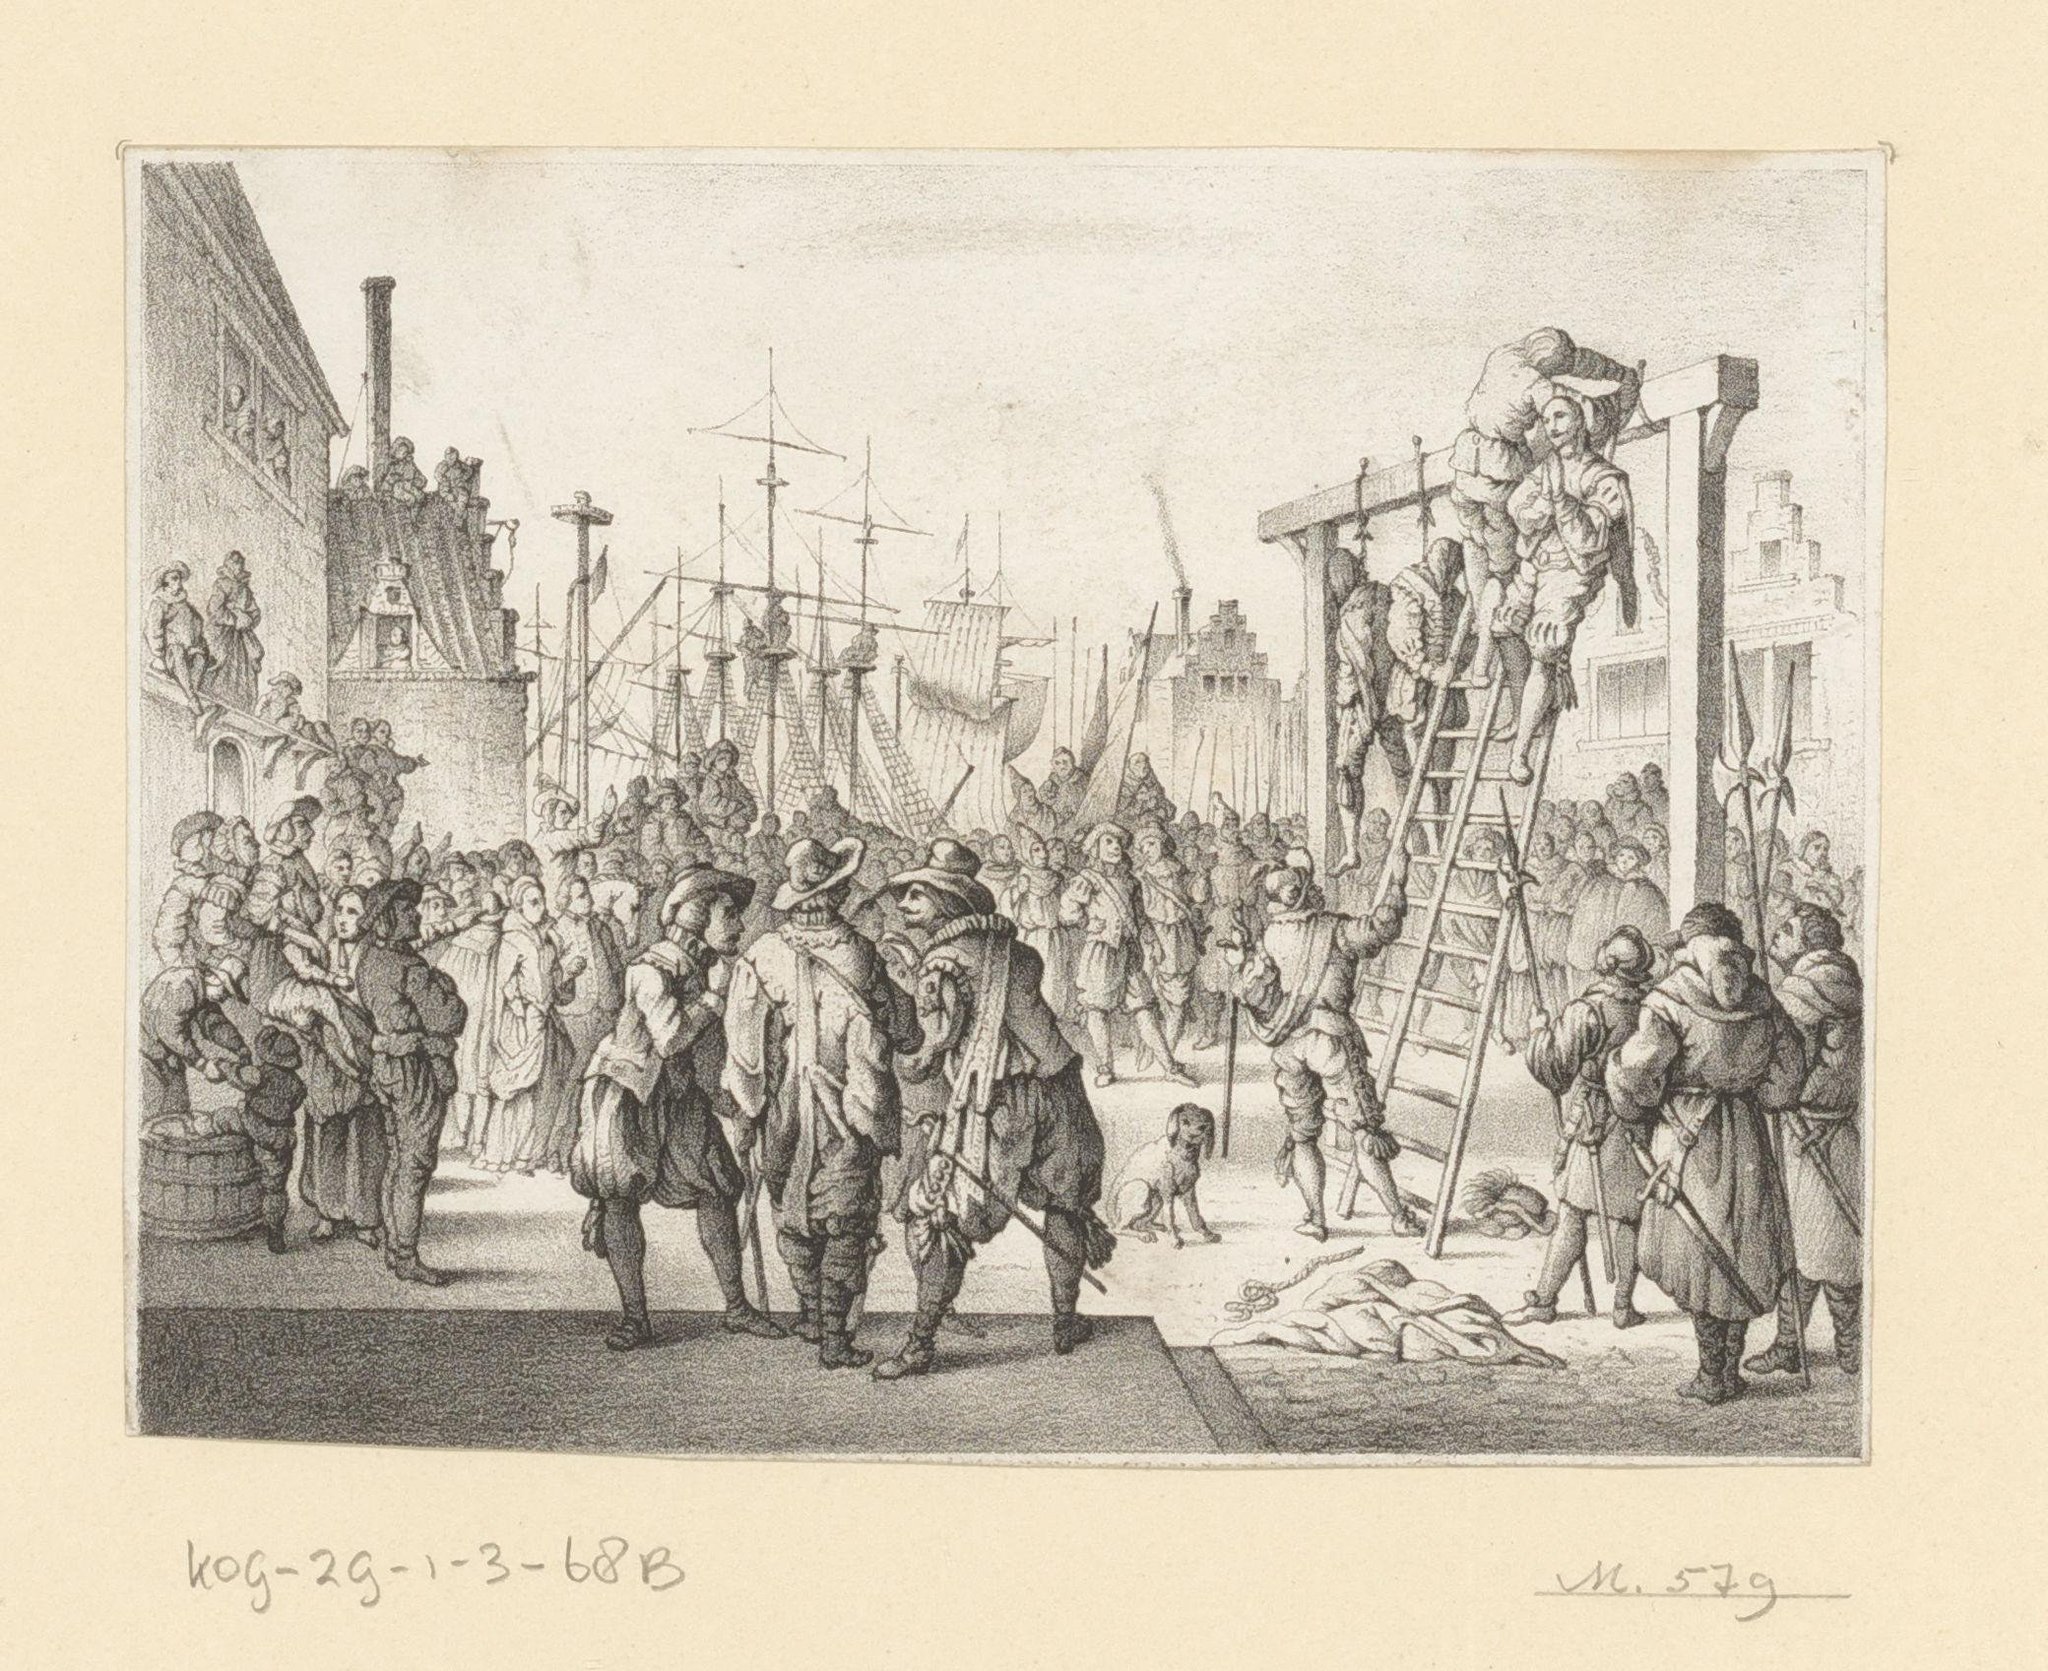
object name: print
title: Pacieco opgehangen te Vlissingen, 1572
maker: Anonymous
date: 1798-1899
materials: paper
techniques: lithograph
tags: flushing, violent death by hanging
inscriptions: collector's mark: Lugt 1641, stamp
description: Don Pedro (of Fernando) Pacieco, krijgsbouwmeester (ingenieur) van de hertog van Alva wordt met twee andere Spanjaarden opgehangen te Vlissingen, 8 april 1572. Met vele toeschouwers, op de achtergrond de masten van de schepen aan de kade. Onderwerpsrubrieken binnen de Atlas Zeden en Gewoonten: Regeering, Rechtswezen.